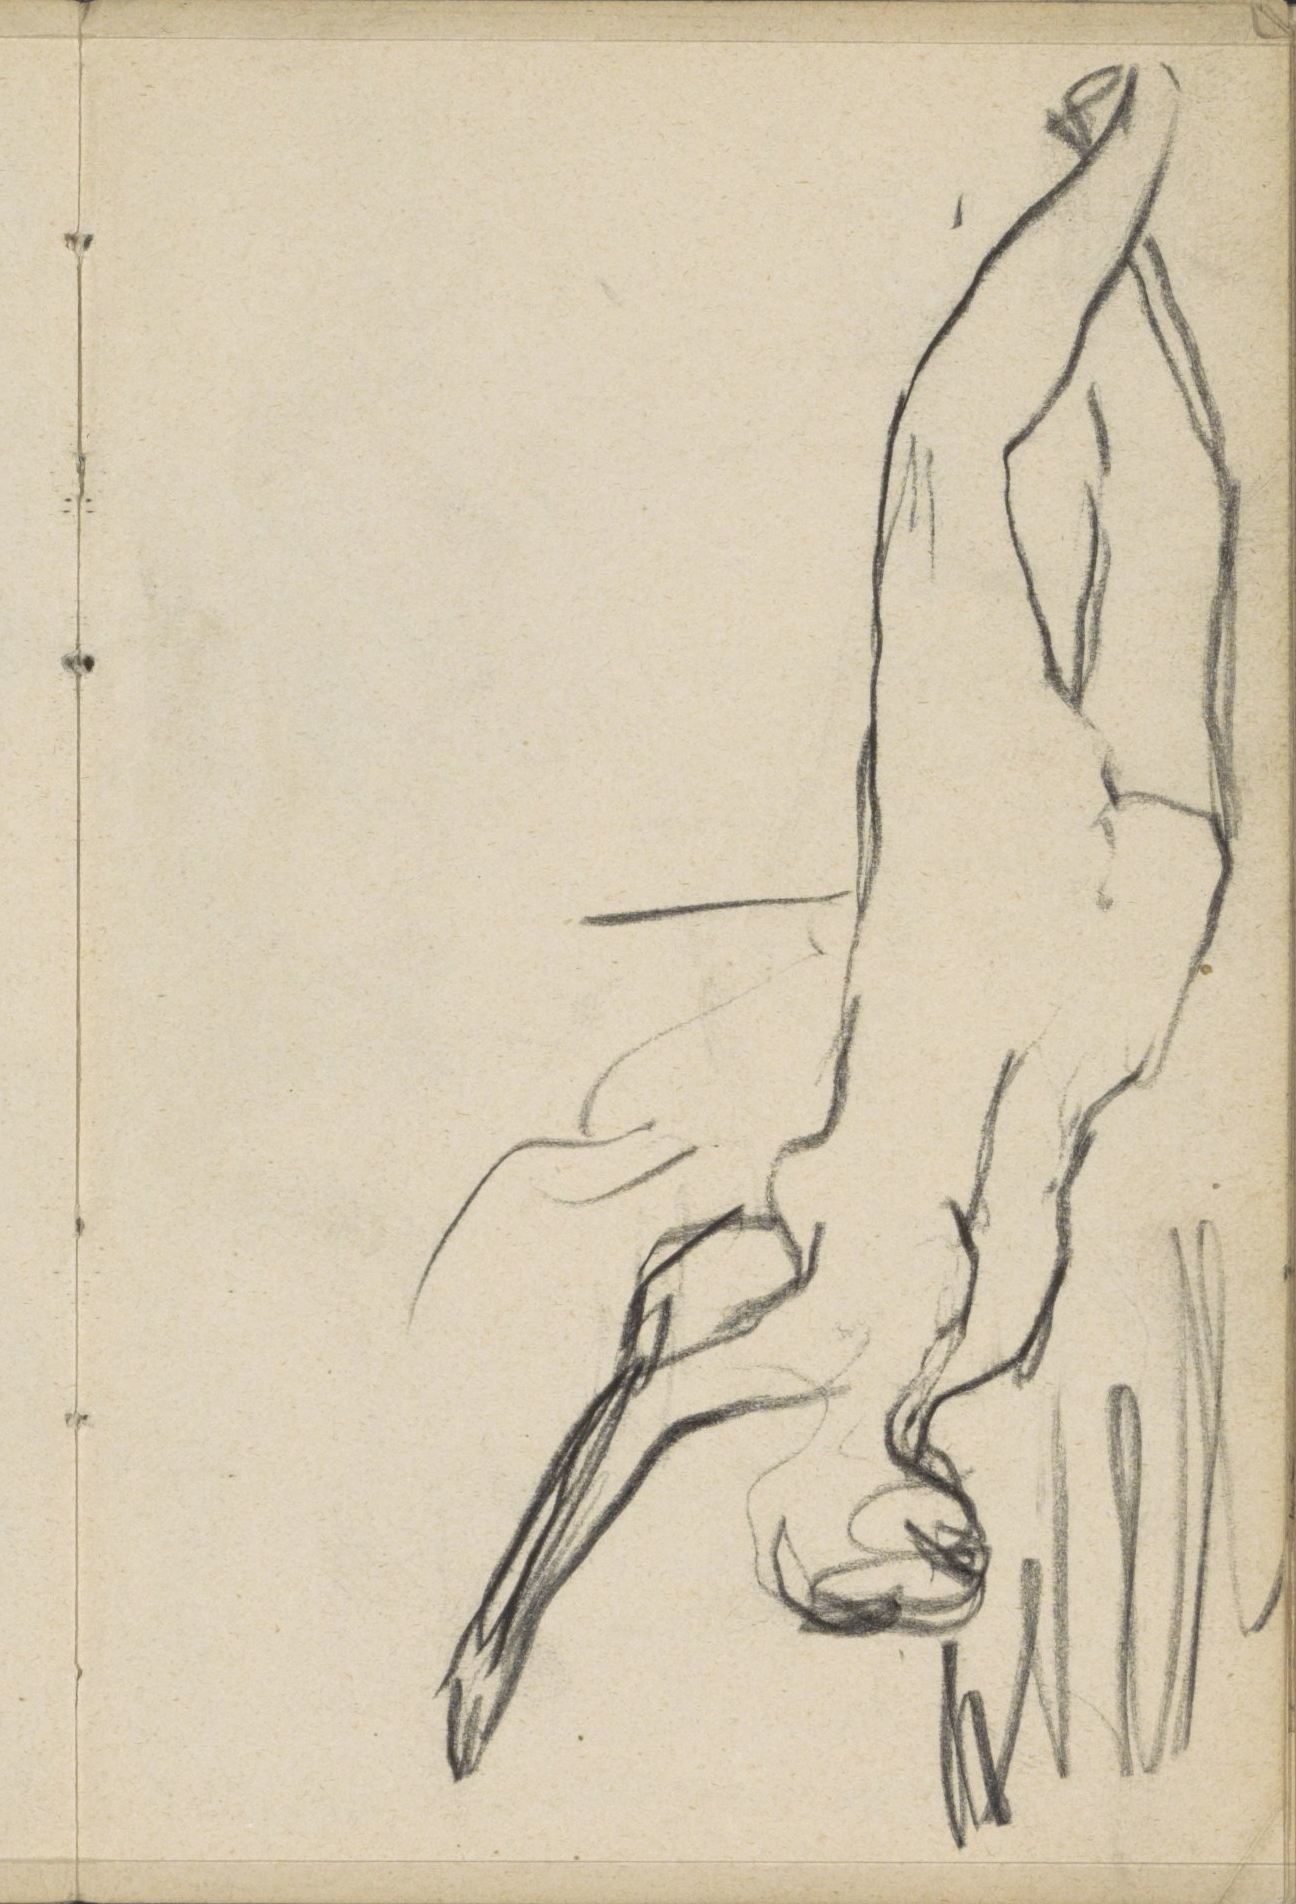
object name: sketchbook leaf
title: Vrouwelijk naakt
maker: george hendrik breitner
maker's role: draughtsman, painter, print maker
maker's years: 1857-1923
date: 1892-1923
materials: chalk, paper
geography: amsterdam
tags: the (nude) human figure; 'corpo humano' (ripa) - aa - female human figure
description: Vrouwelijk naakt met opgeheven rechterarm. Pagina 65 uit een schetsboek met 45 bladen vervaardigd te Schwerin en Amsterdam.